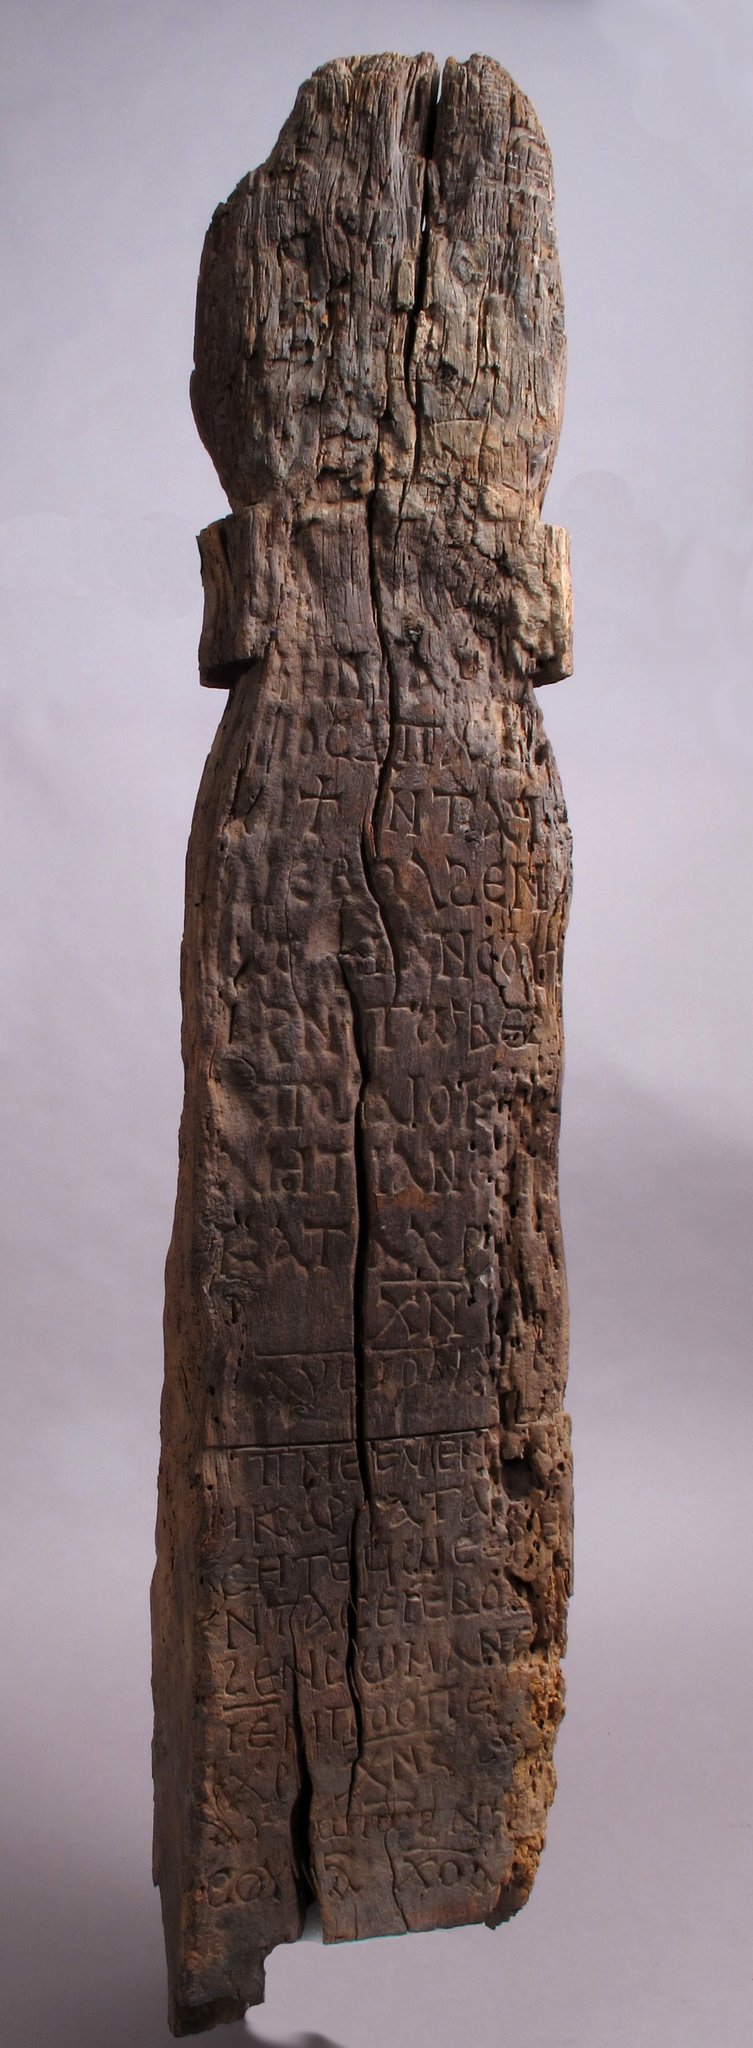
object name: grave monument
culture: byzantine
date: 901-1000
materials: wood